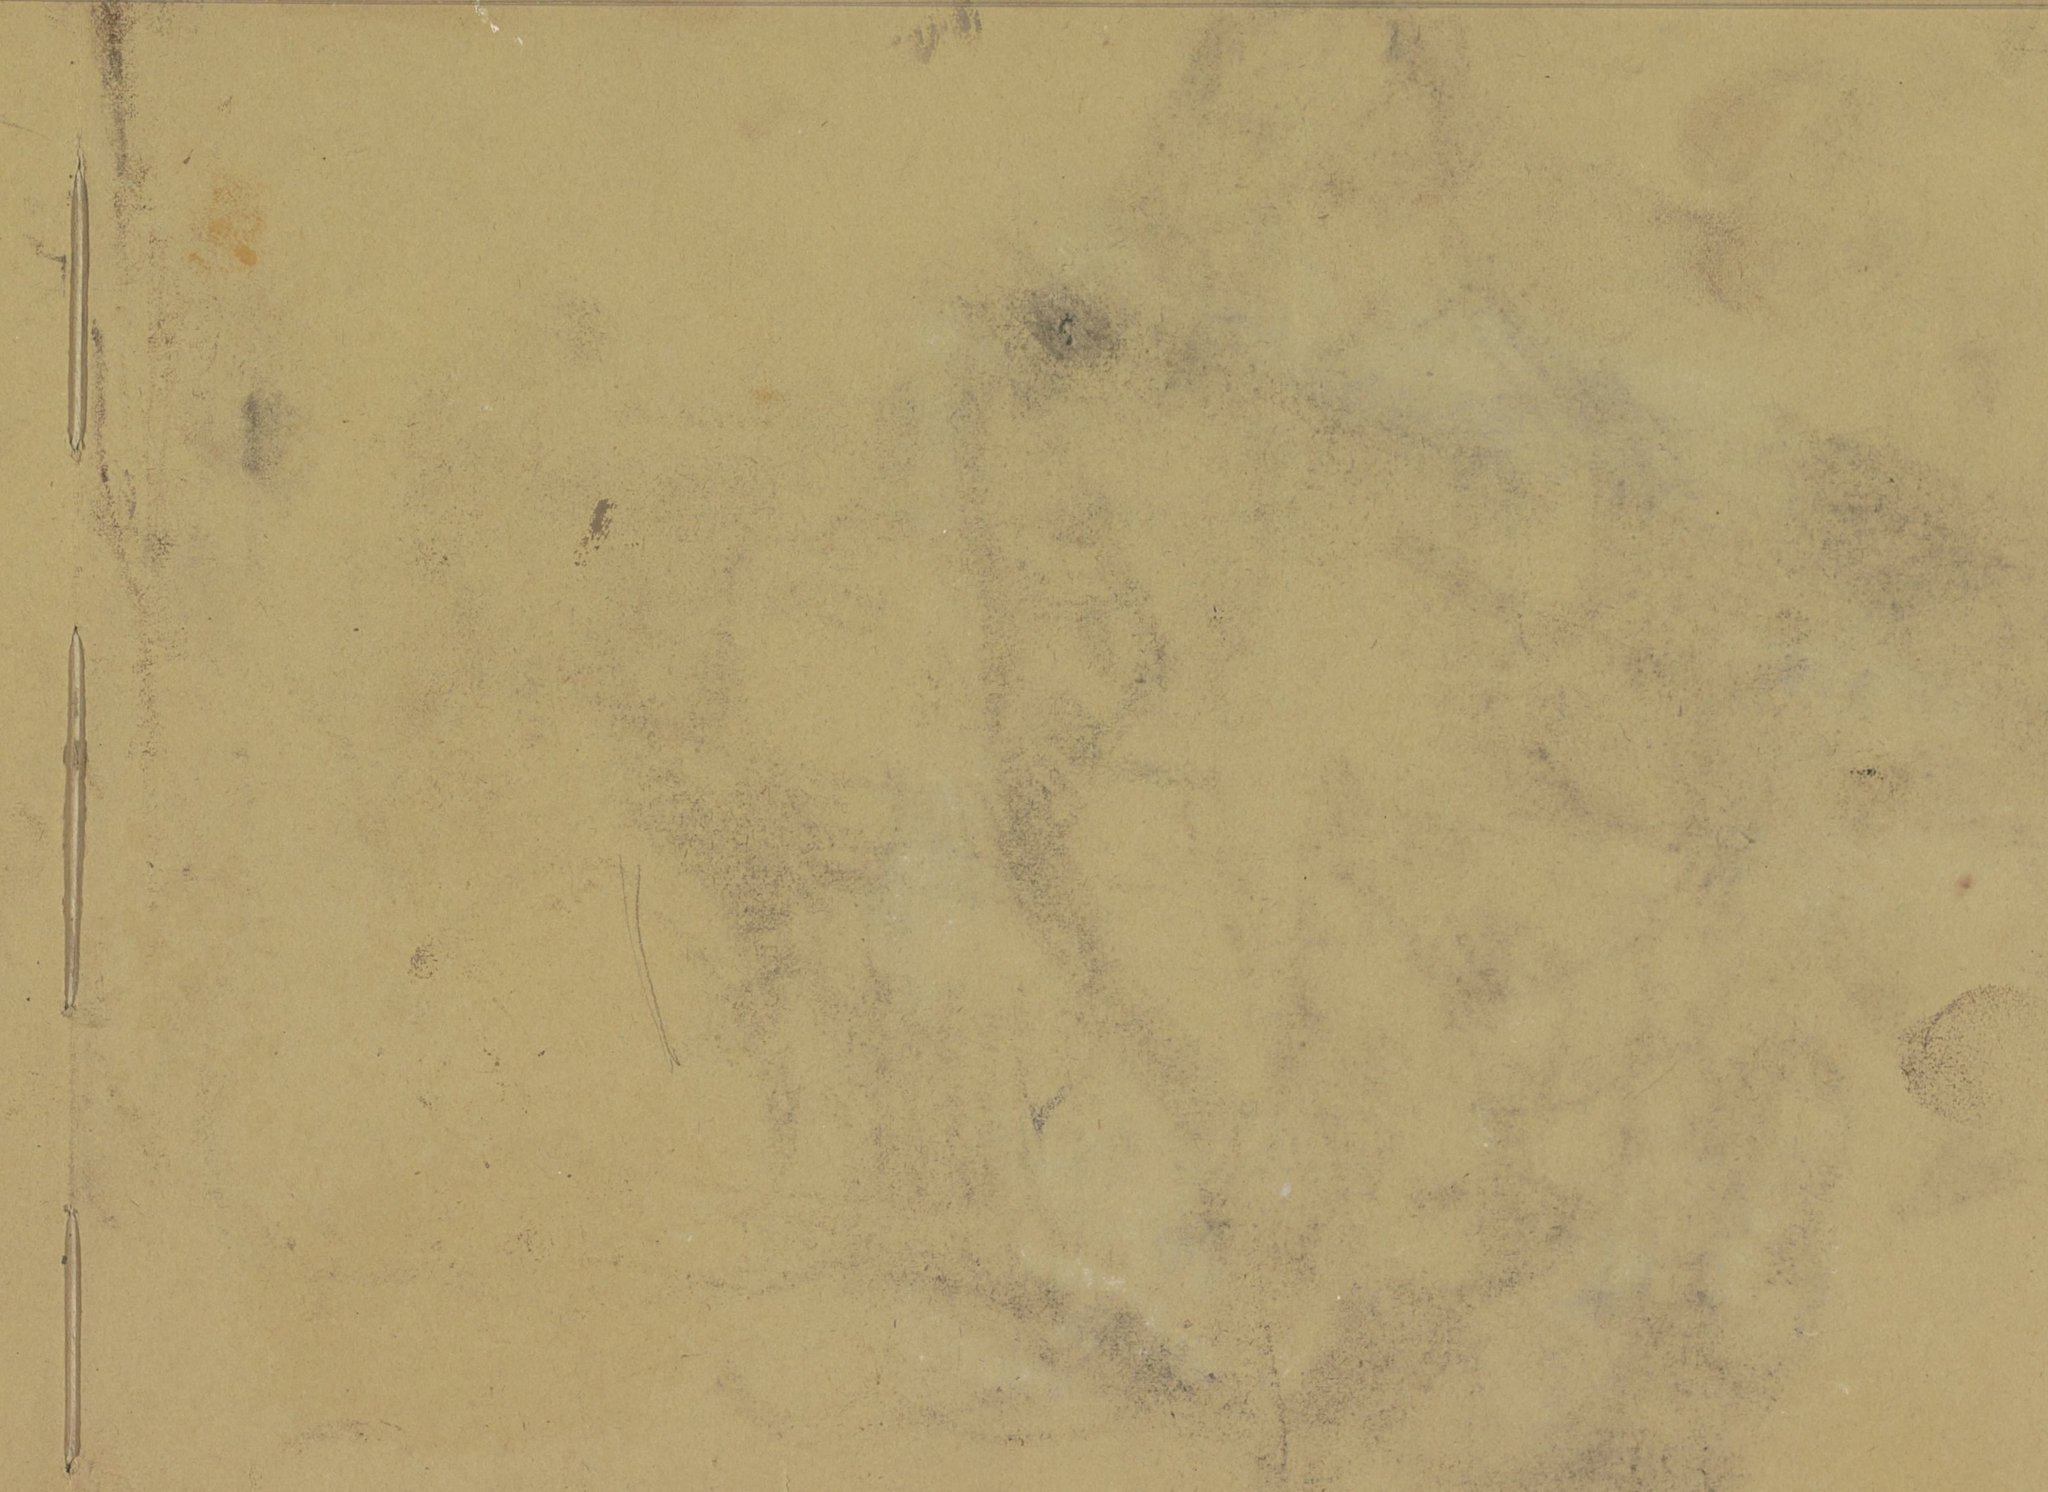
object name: sketchbook leaf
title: Abklatsch van de krijttekening op blad 27 verso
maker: isaac israels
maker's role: draughtsman, painter, print maker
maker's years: 1865-1934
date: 1890-1920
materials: paper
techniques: printmaking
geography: the hague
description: Blad 28 recto uit schetsboek X met 43 bladen.